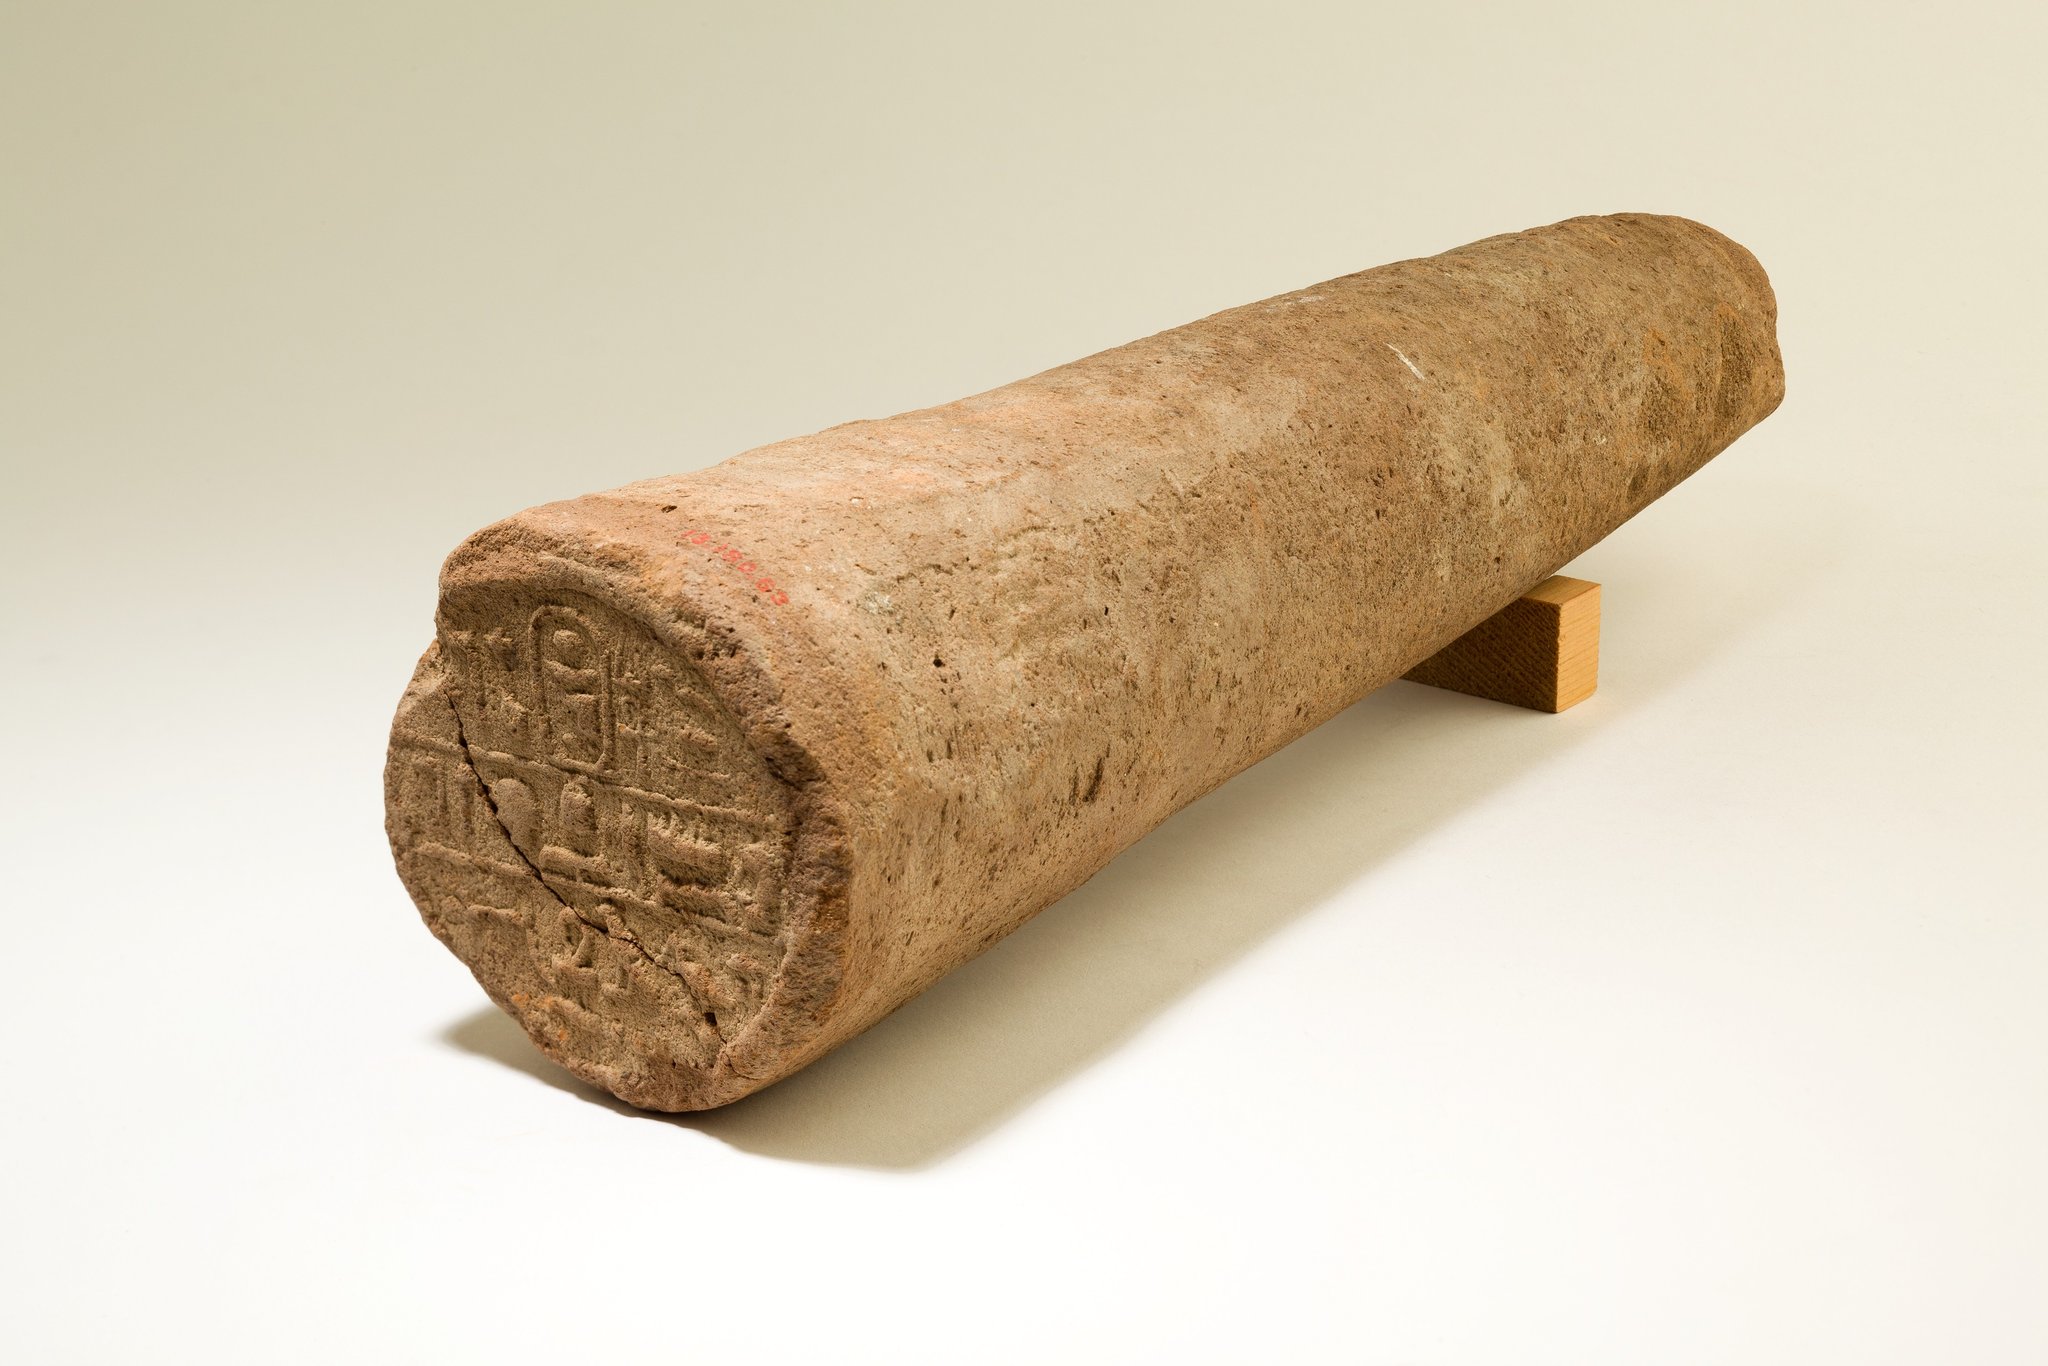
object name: cone, curcular impression, djehuty, first prophet of amun, seal bearer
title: Funerary Cone of High Priest of Amun Djehuty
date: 1550-1525 BCE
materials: pottery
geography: egypt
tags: hieroglyphs